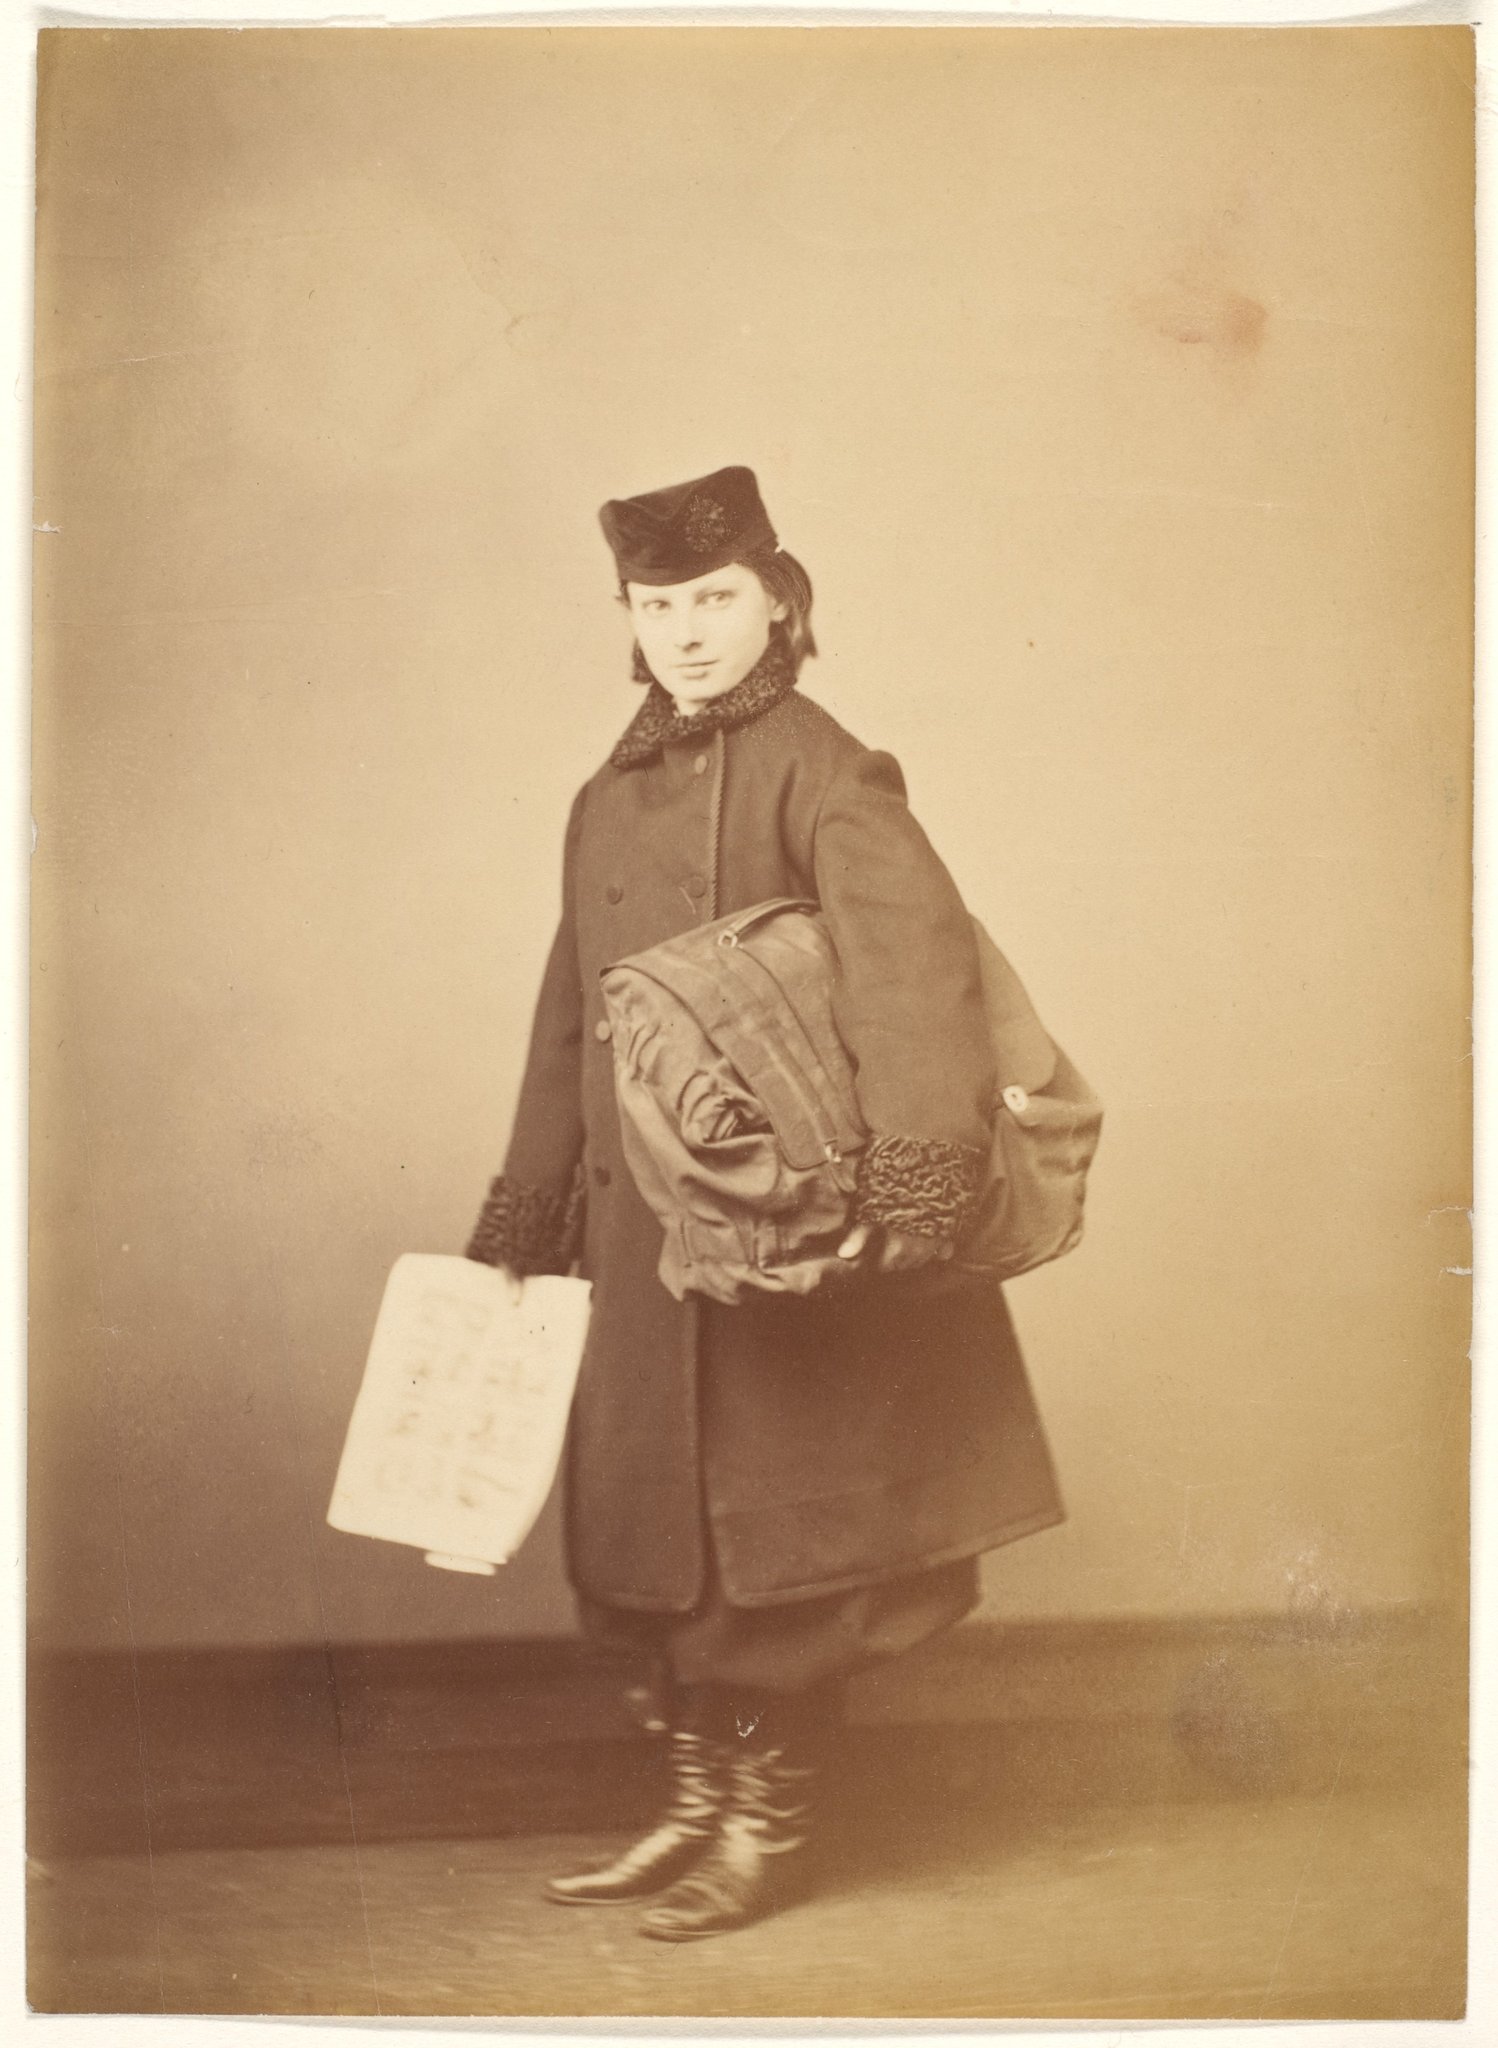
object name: photograph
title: Le Grand Russe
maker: pierre-louis pierson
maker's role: artist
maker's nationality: french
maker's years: 1822-1913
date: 1860-1869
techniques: albumen silver print, glass negative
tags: children,portraits